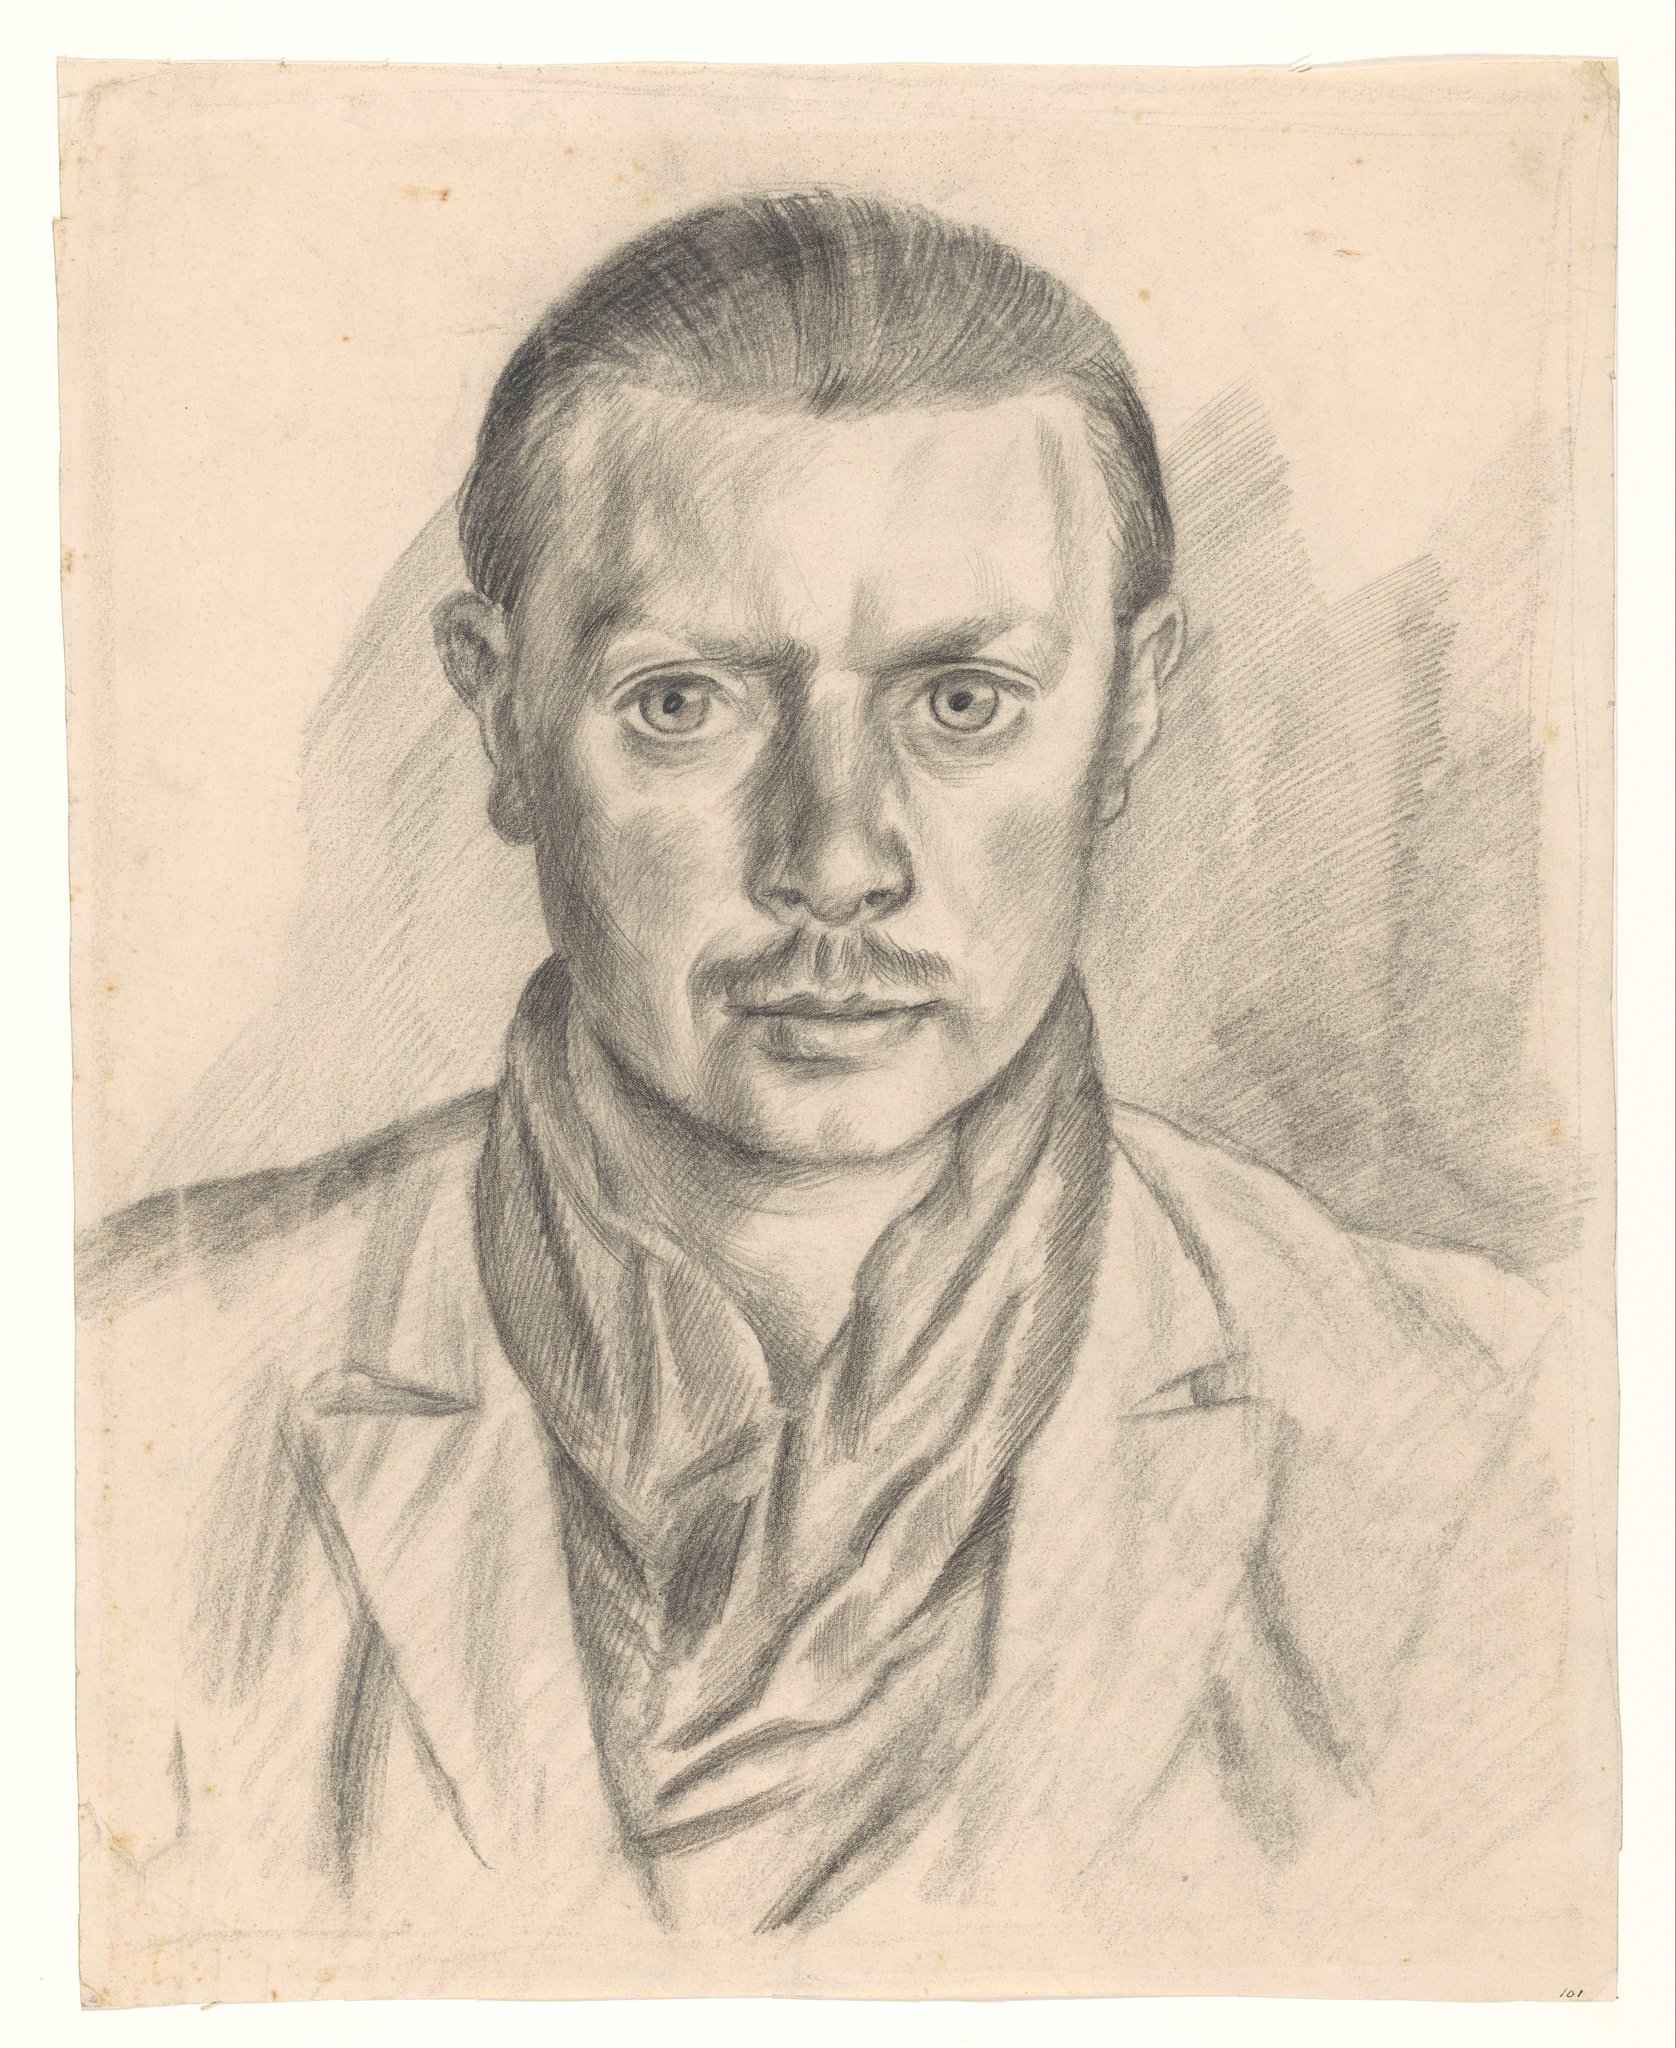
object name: drawing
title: Zelfportret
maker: henk henriët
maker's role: draughtsman, print maker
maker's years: 1903-1945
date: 1913-1945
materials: chalk, paper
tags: amsterdam, print maker, draughtsman, henk henriët, historical persons, portrait, self-portrait of artist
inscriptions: collector's mark: Lugt 2228, workshop stamp: ‘Atelier H. Henriët’, inscription: ‘101’, inscription: ‘101 J.J.H.’